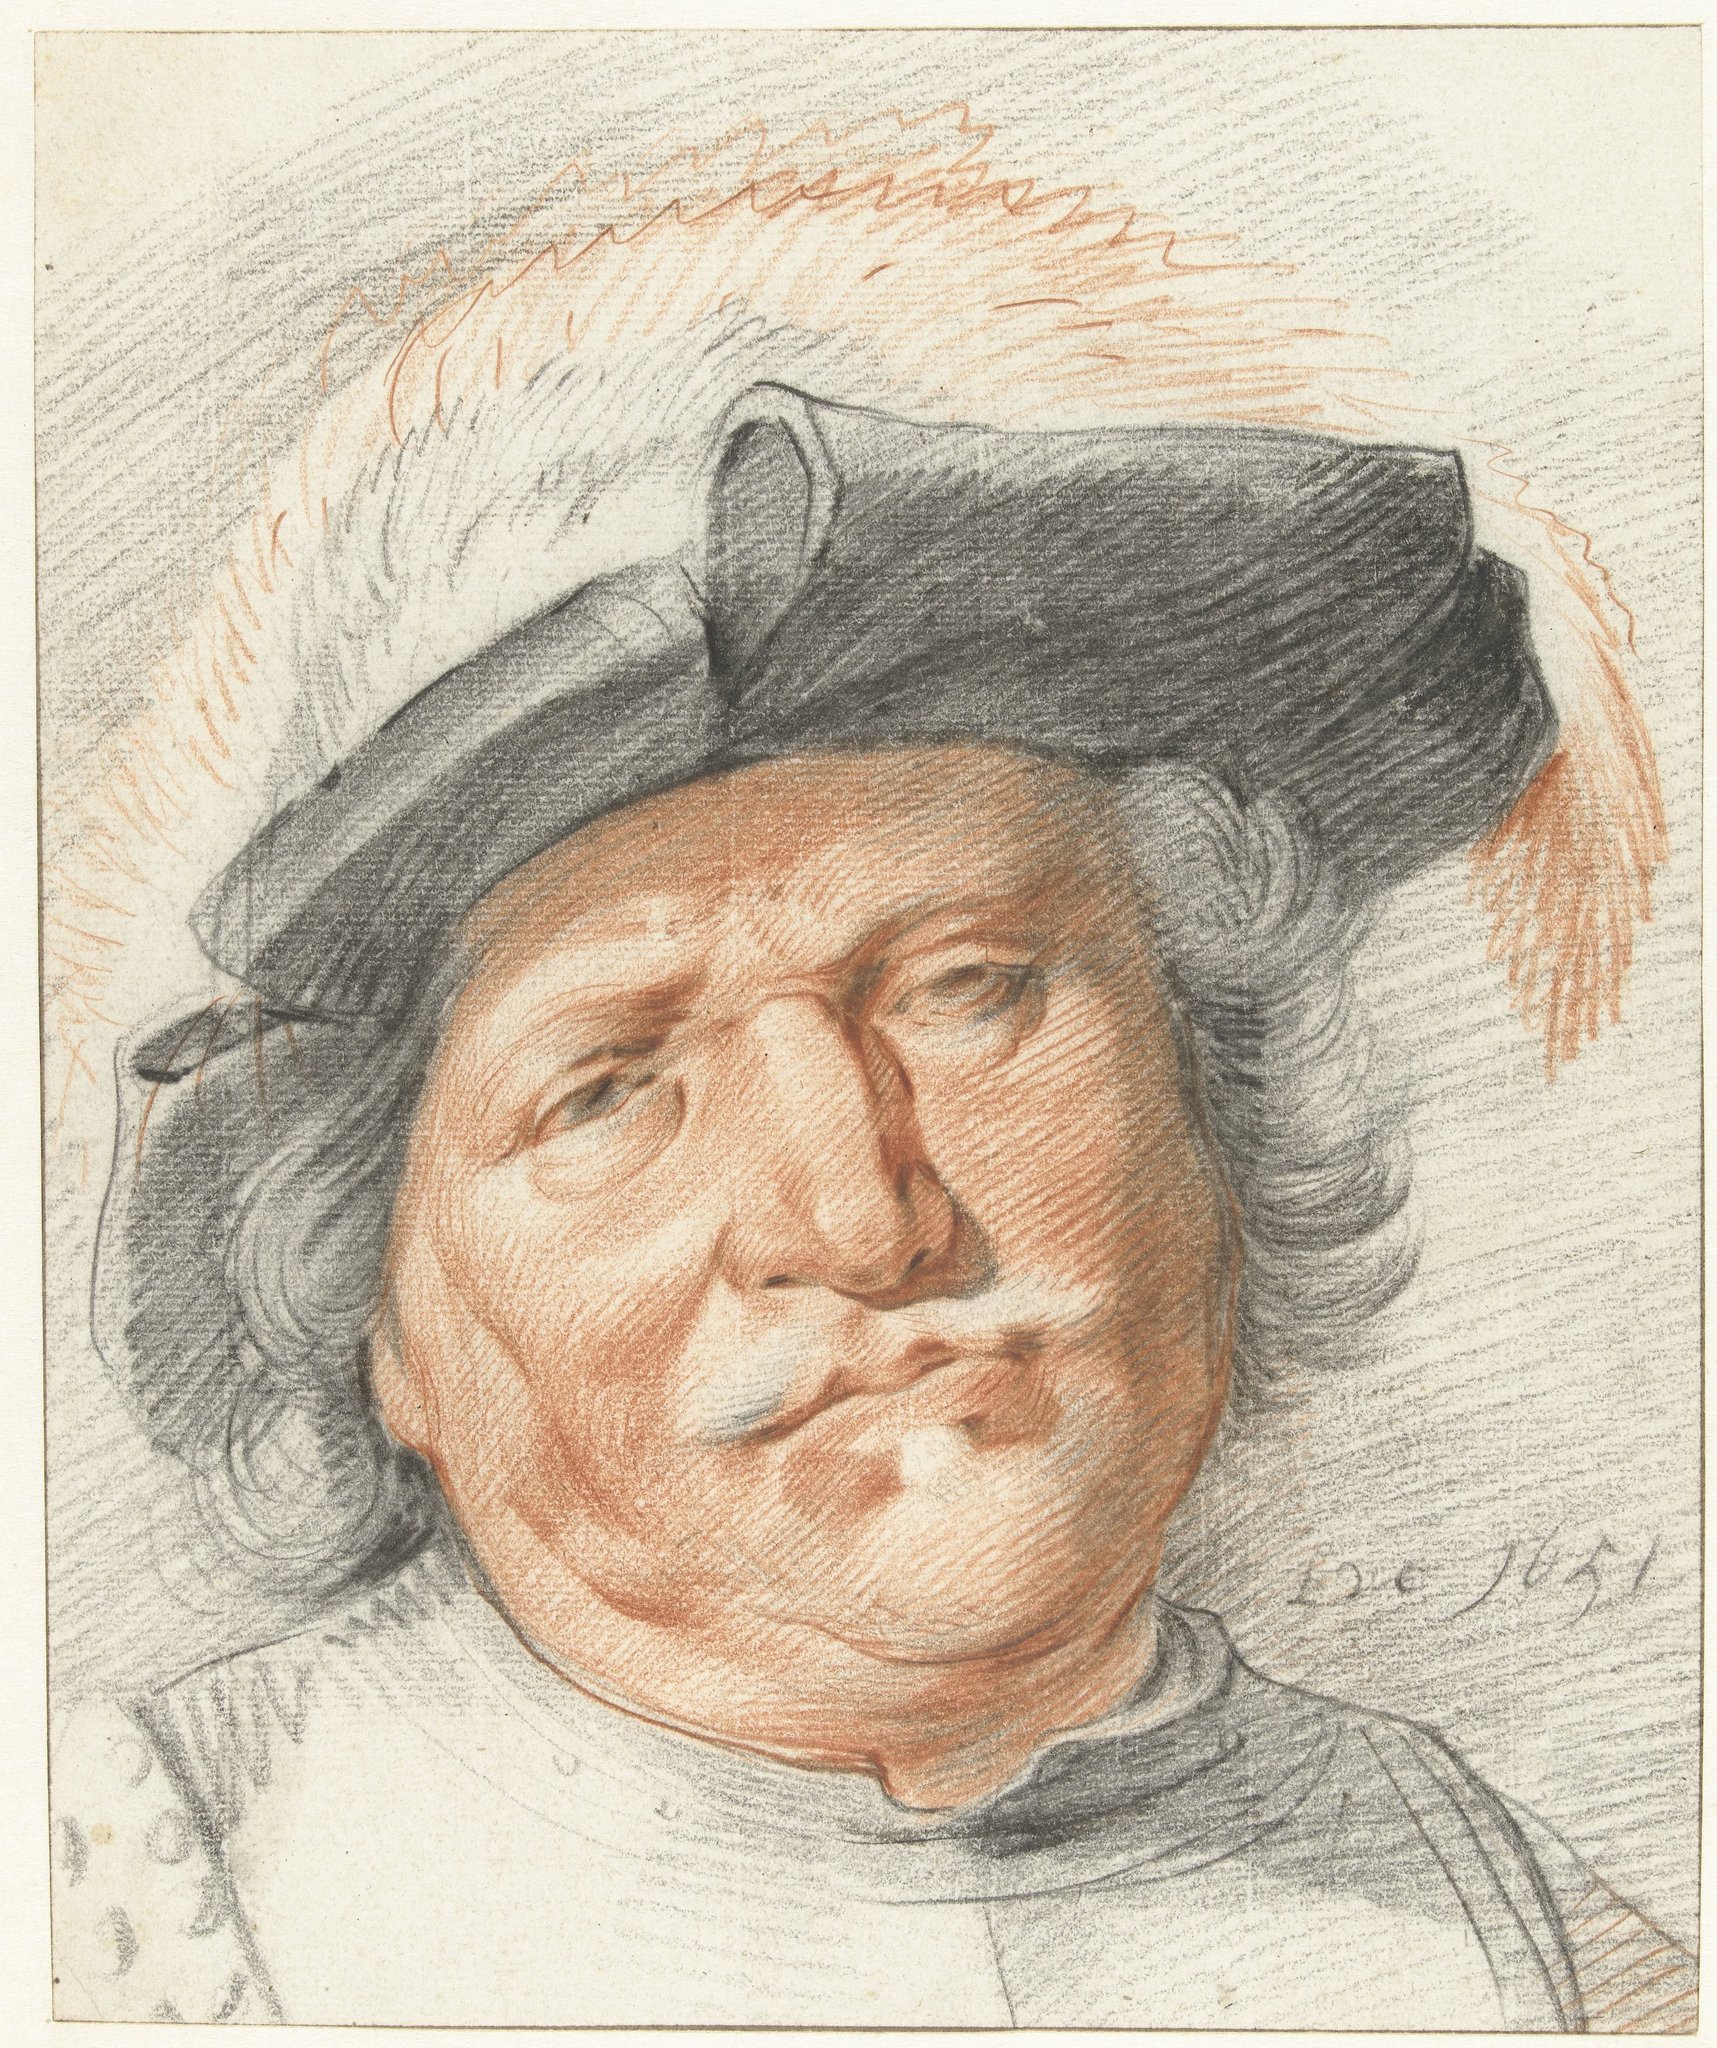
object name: drawing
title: Hoofd van een man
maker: leendert van der cooghen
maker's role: draughtsman, print maker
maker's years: 1632-1681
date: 1651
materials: chalk, paper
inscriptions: date: ‘1651’